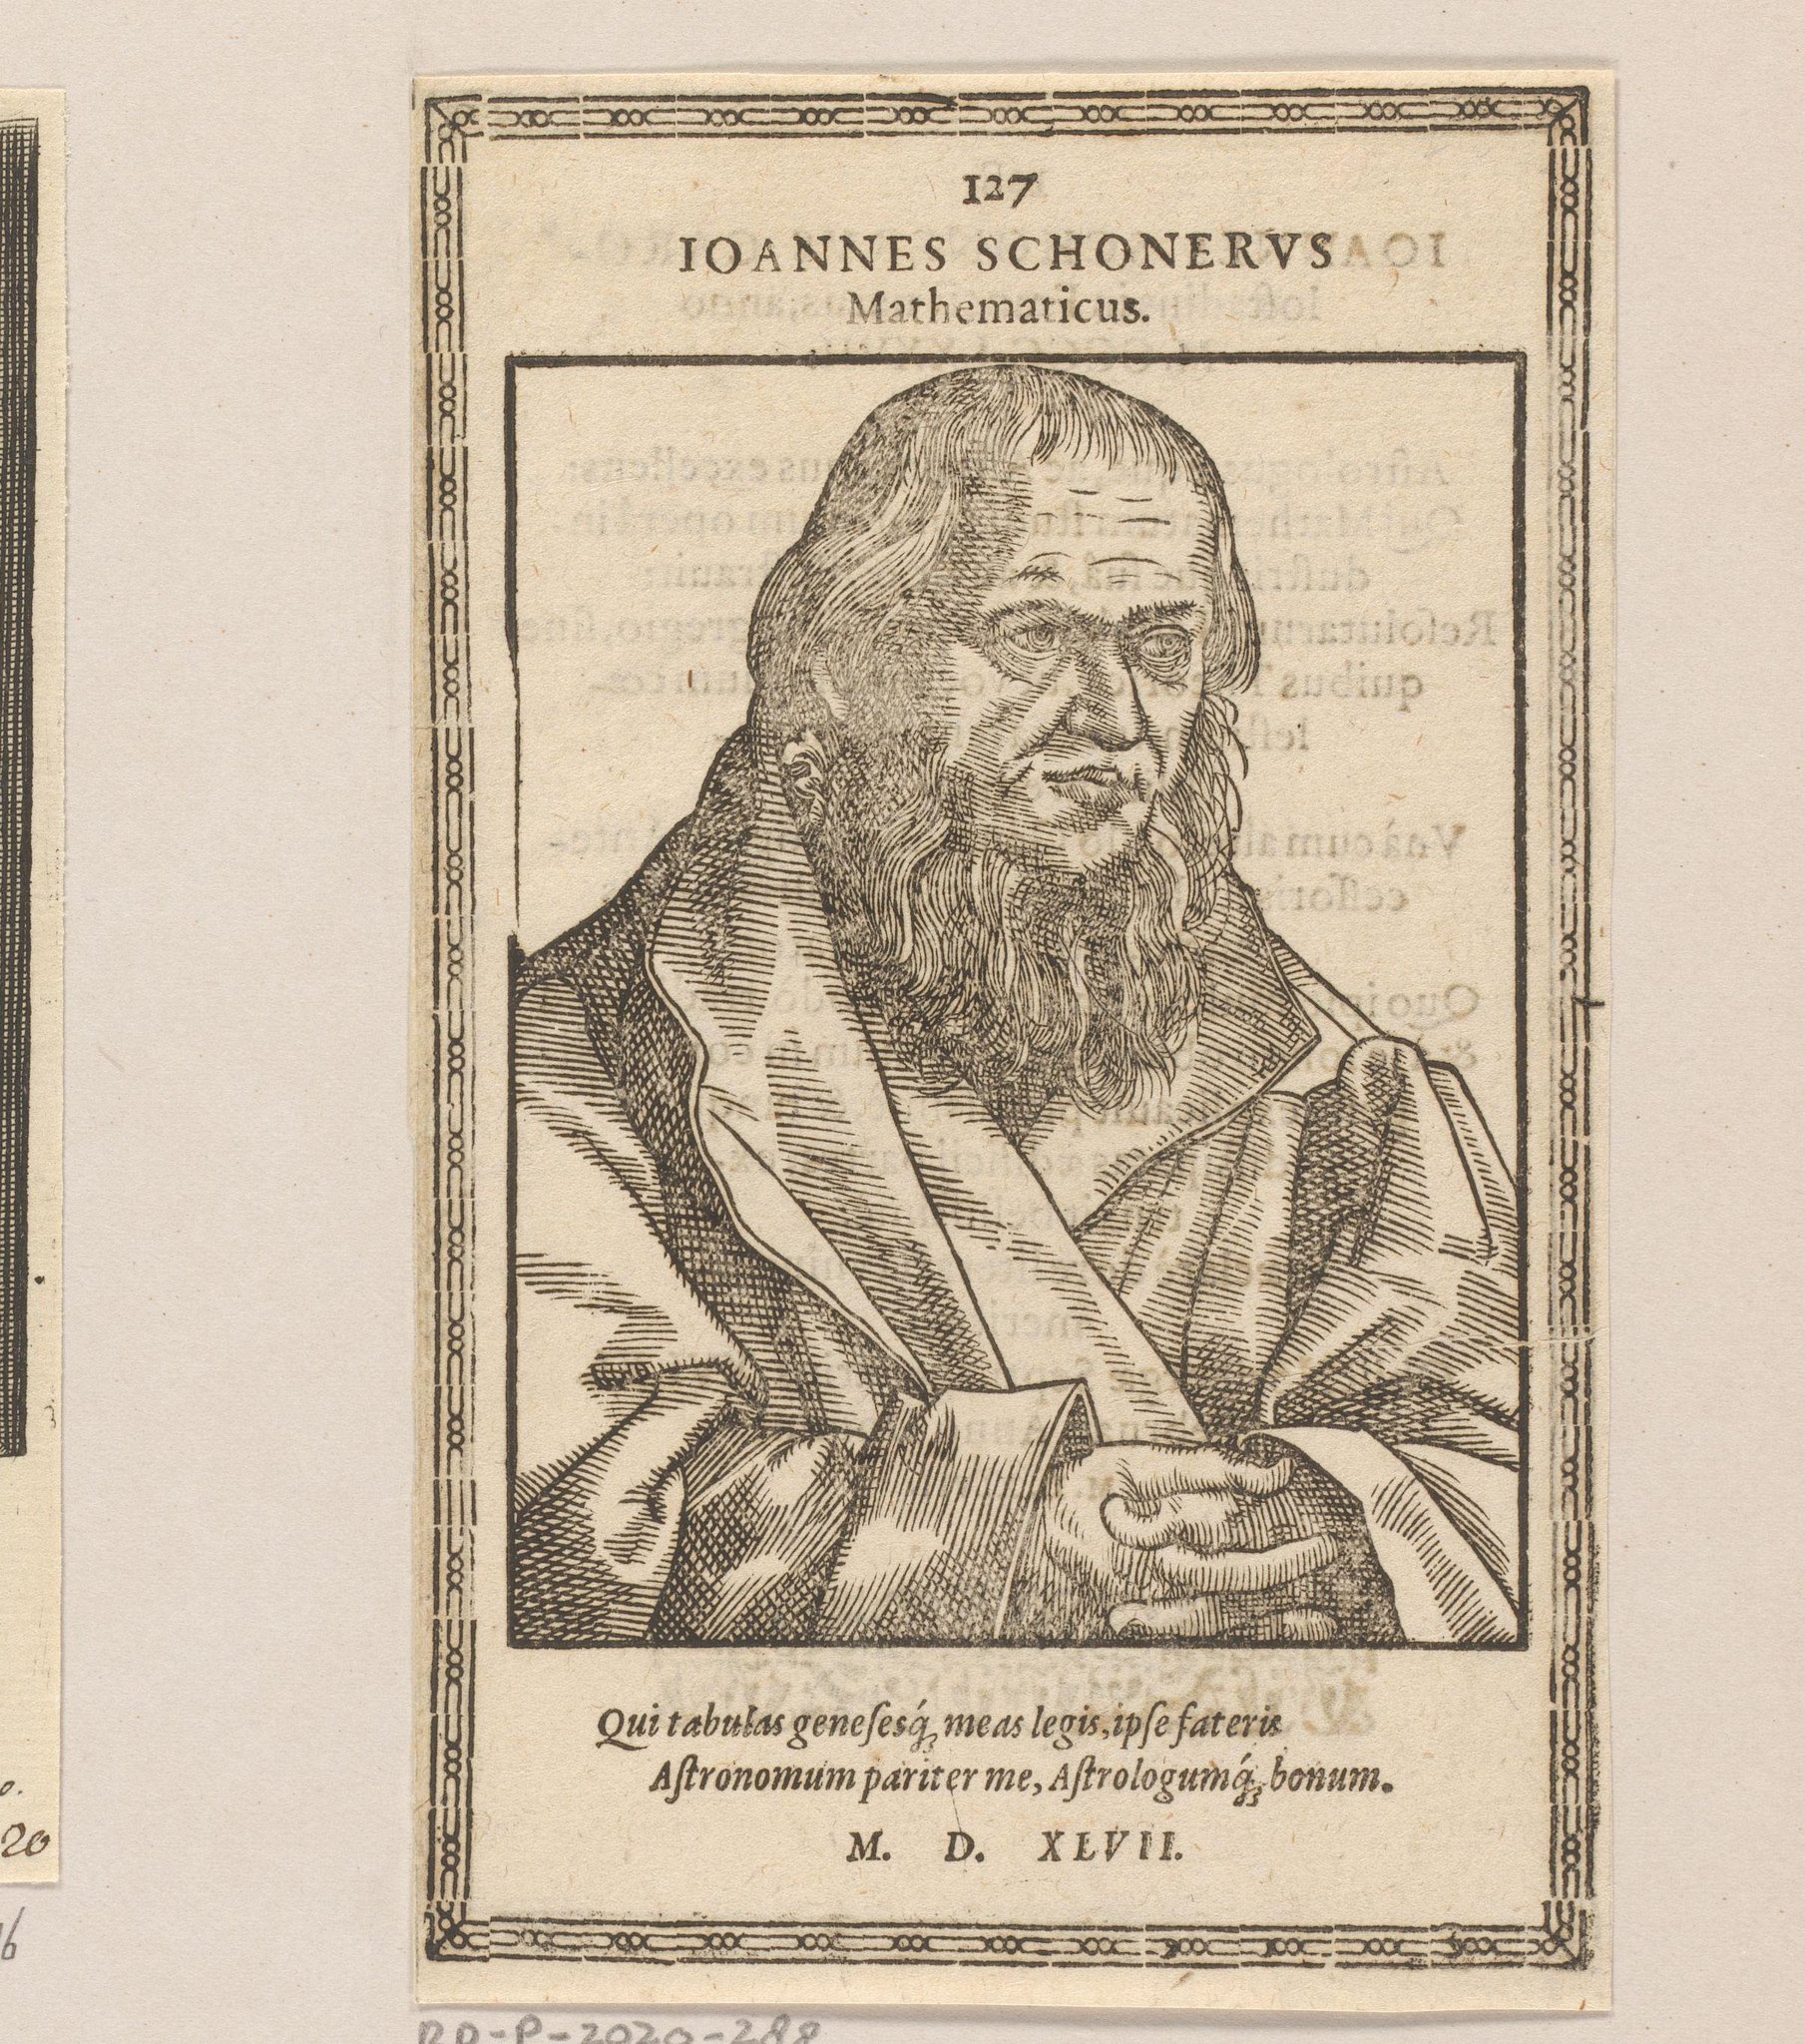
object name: book illustration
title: Portret van Johannes Schöner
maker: bernhard jobin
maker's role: printer, publisher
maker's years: 1545-1593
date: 1590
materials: paper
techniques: letterpress printing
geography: straatsburg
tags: historical persons, mathematics (+ portrait of scholar, scientist)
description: Prent uit: Reusner, Nikolaus. Icones sive imagines virorum literis illustrium (...). Straatsburg: Bernhard Jobin, 1590, p. 127. Prent voor het eerst verschenen in de eerste editie van 1587. Prent mogelijk ook gebruikt in latere publicaties.